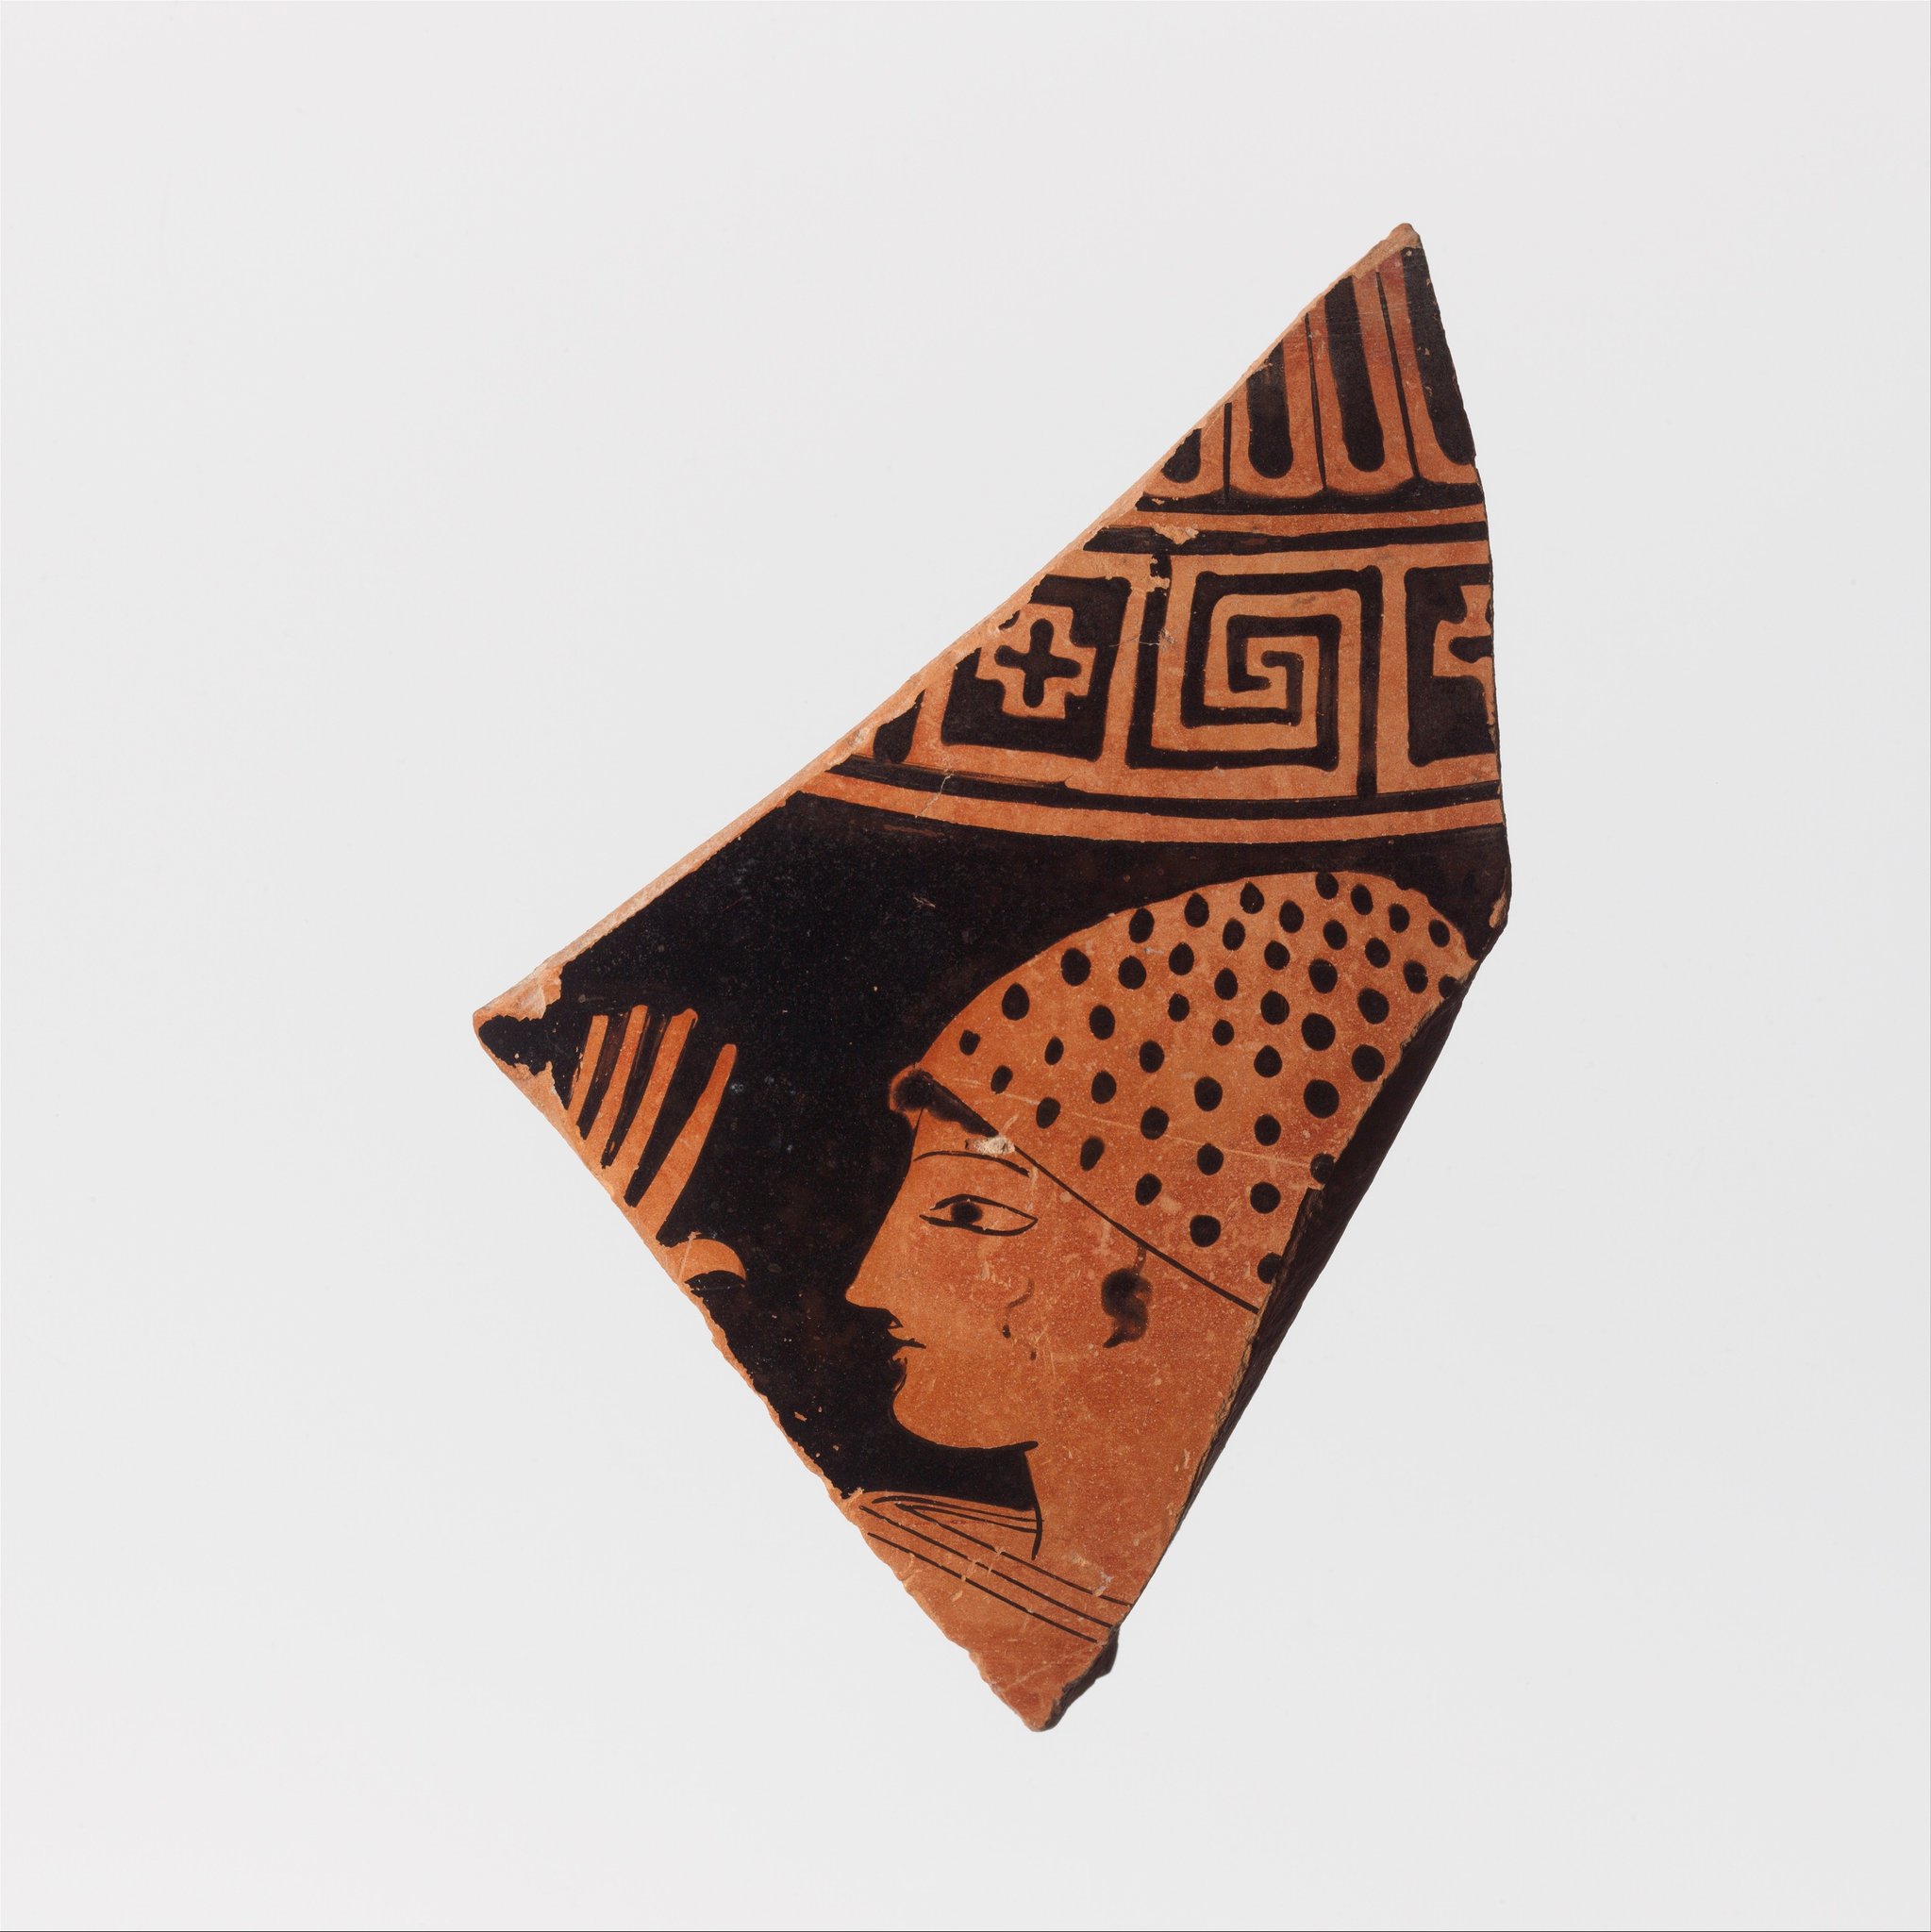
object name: lebes gamikos fragment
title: Fragment of a terracotta lebes gamikos (round-bottomed bowl with handles and stand used in weddings)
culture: greek, attic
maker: mannerists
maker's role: artist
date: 440 BCE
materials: terracotta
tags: boys,profiles